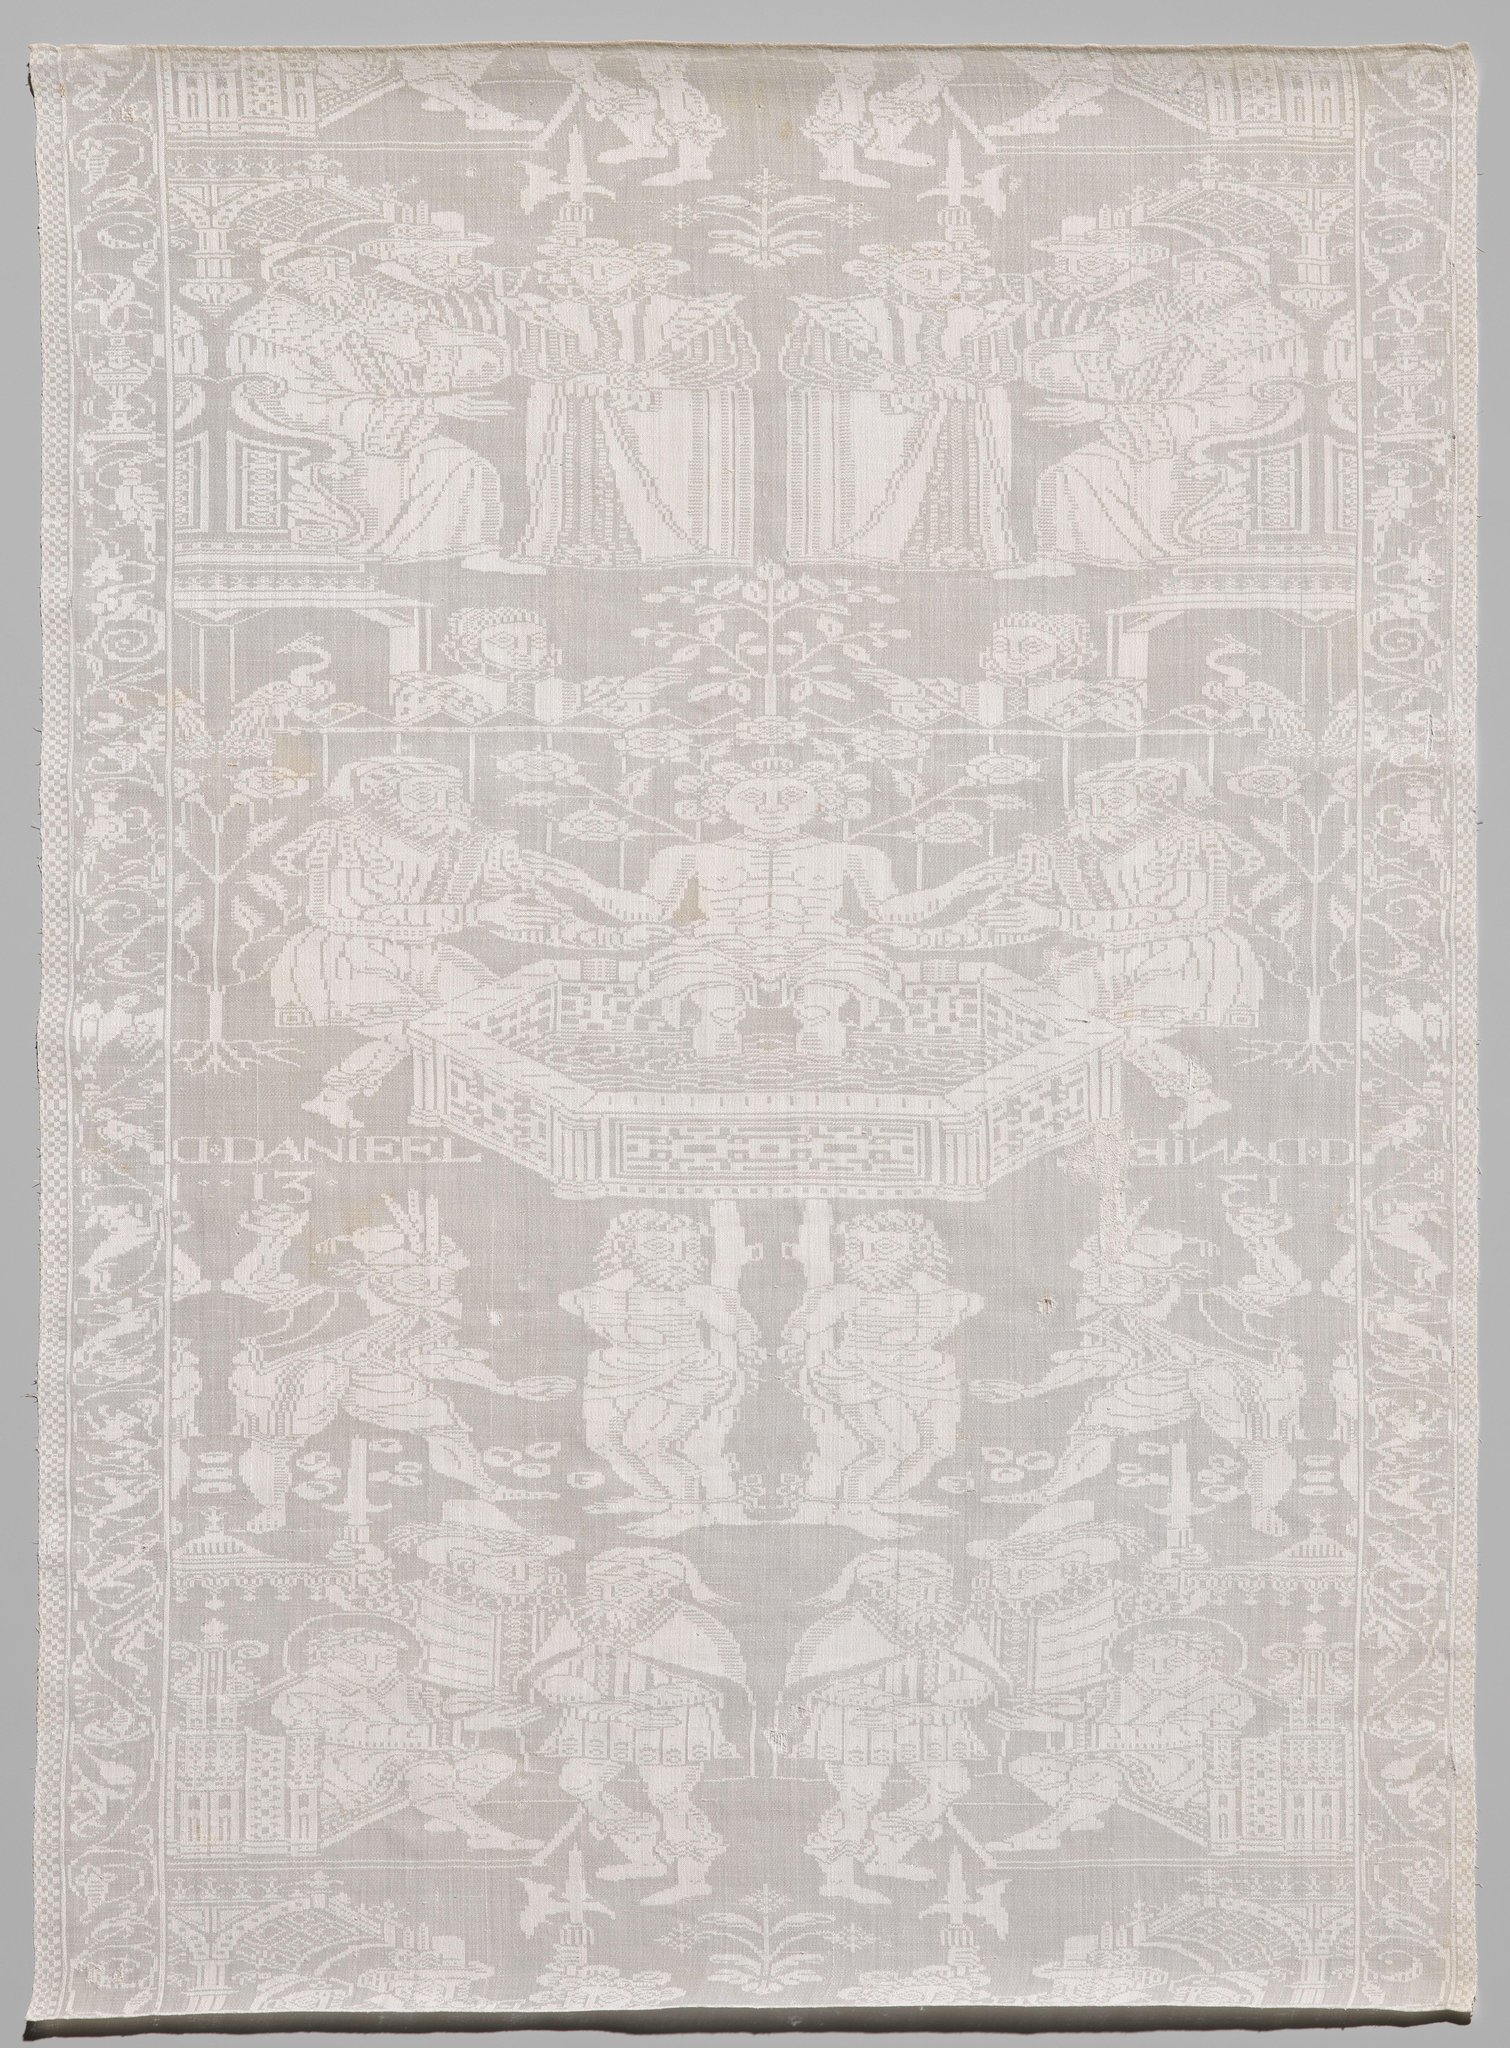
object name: napkin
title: Servet van wit linnendamast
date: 1580-1620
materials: linen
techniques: damask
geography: flanders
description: Wit linnen damasten servet met de apocriefe geschiedenis van Susanna en de Oudsten in vier taferelen.